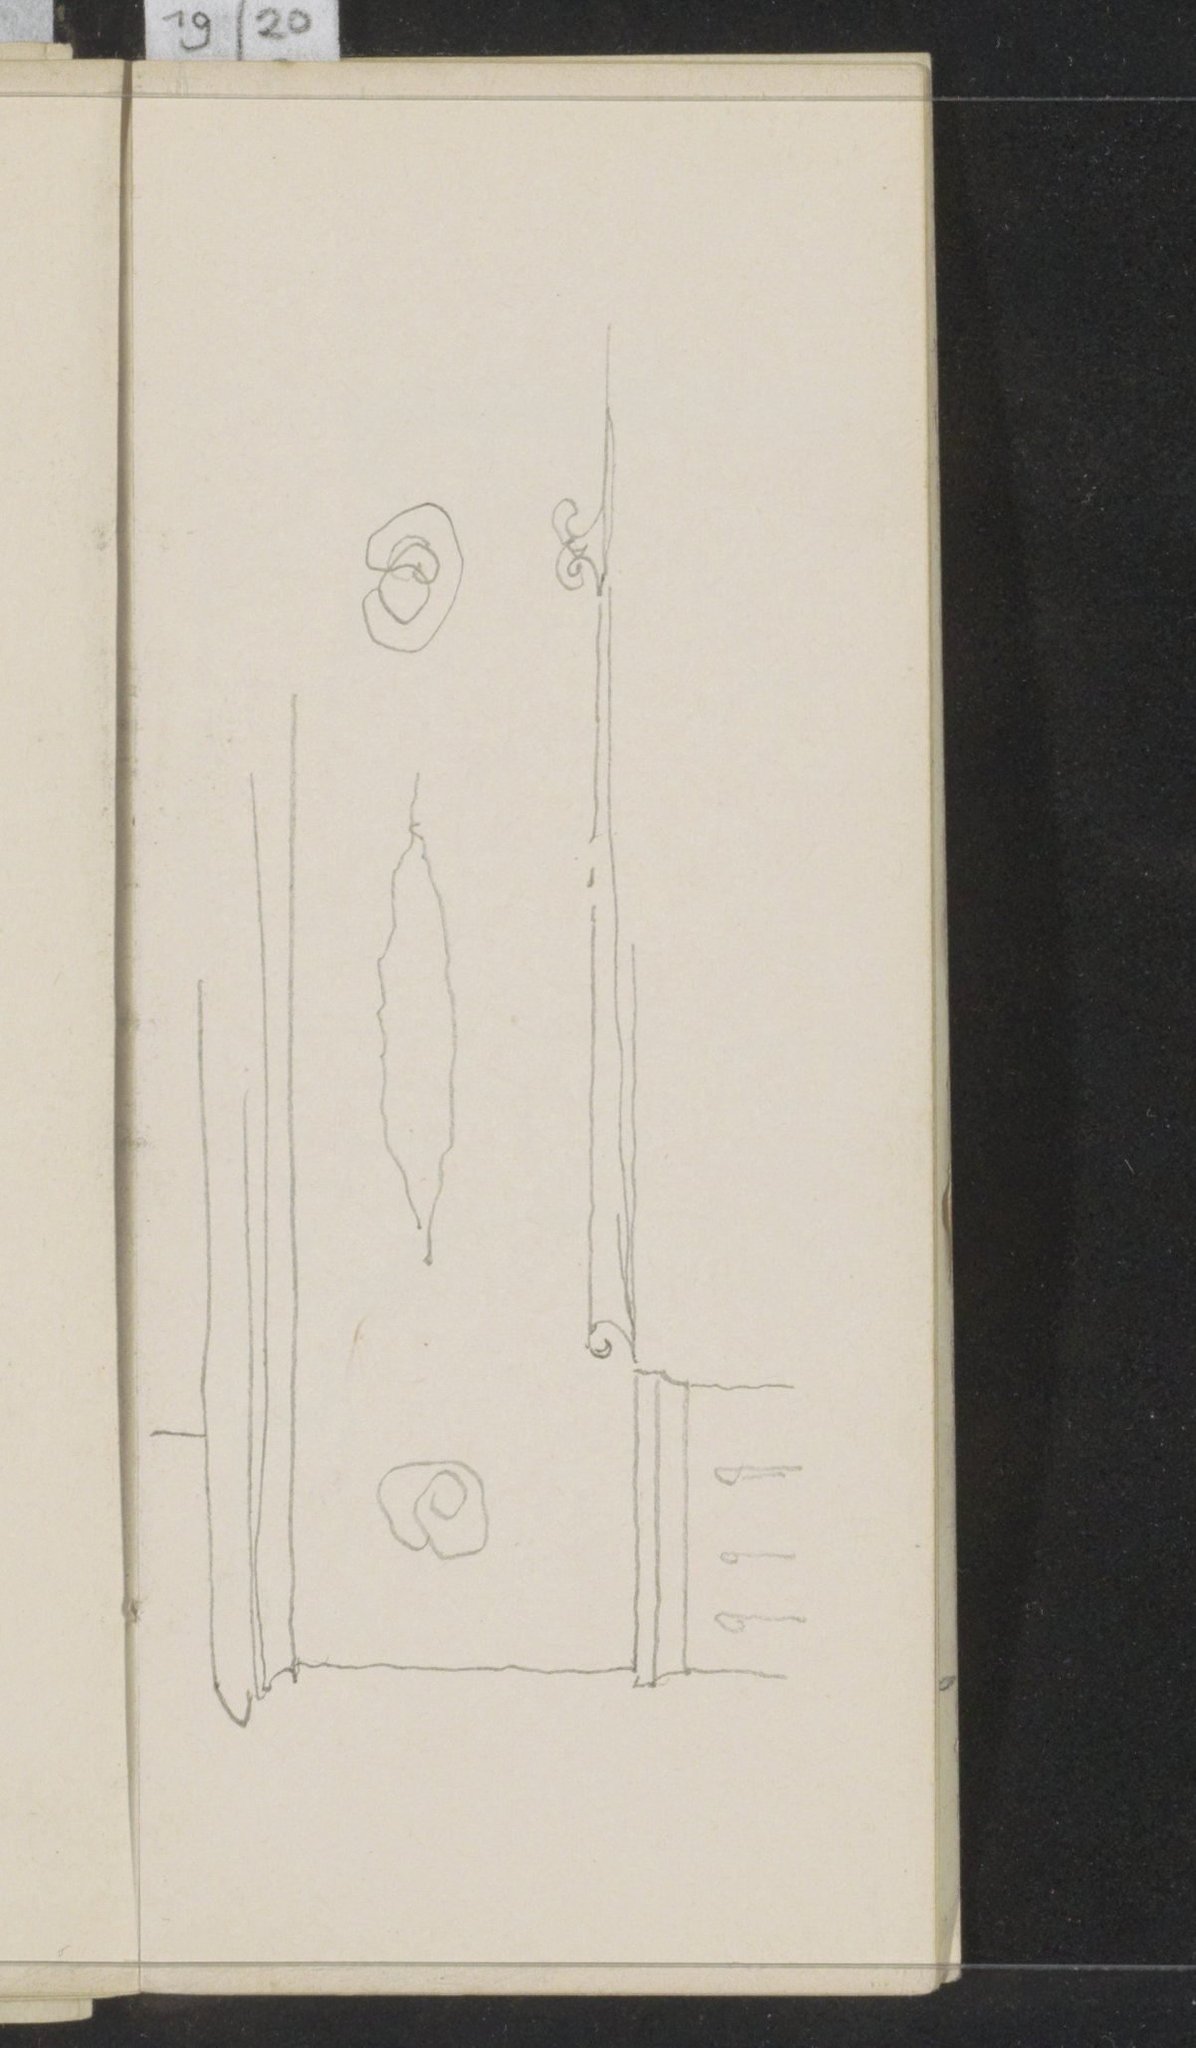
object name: sketchbook leaf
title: Kroonlijst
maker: gerrit willem dijsselhof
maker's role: designer, draughtsman, print maker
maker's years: 1866-1924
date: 1876-1924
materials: paper, pencil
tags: other architectural details (cornice)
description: Blad 19 recto uit een schetsboek met 24 bladen.